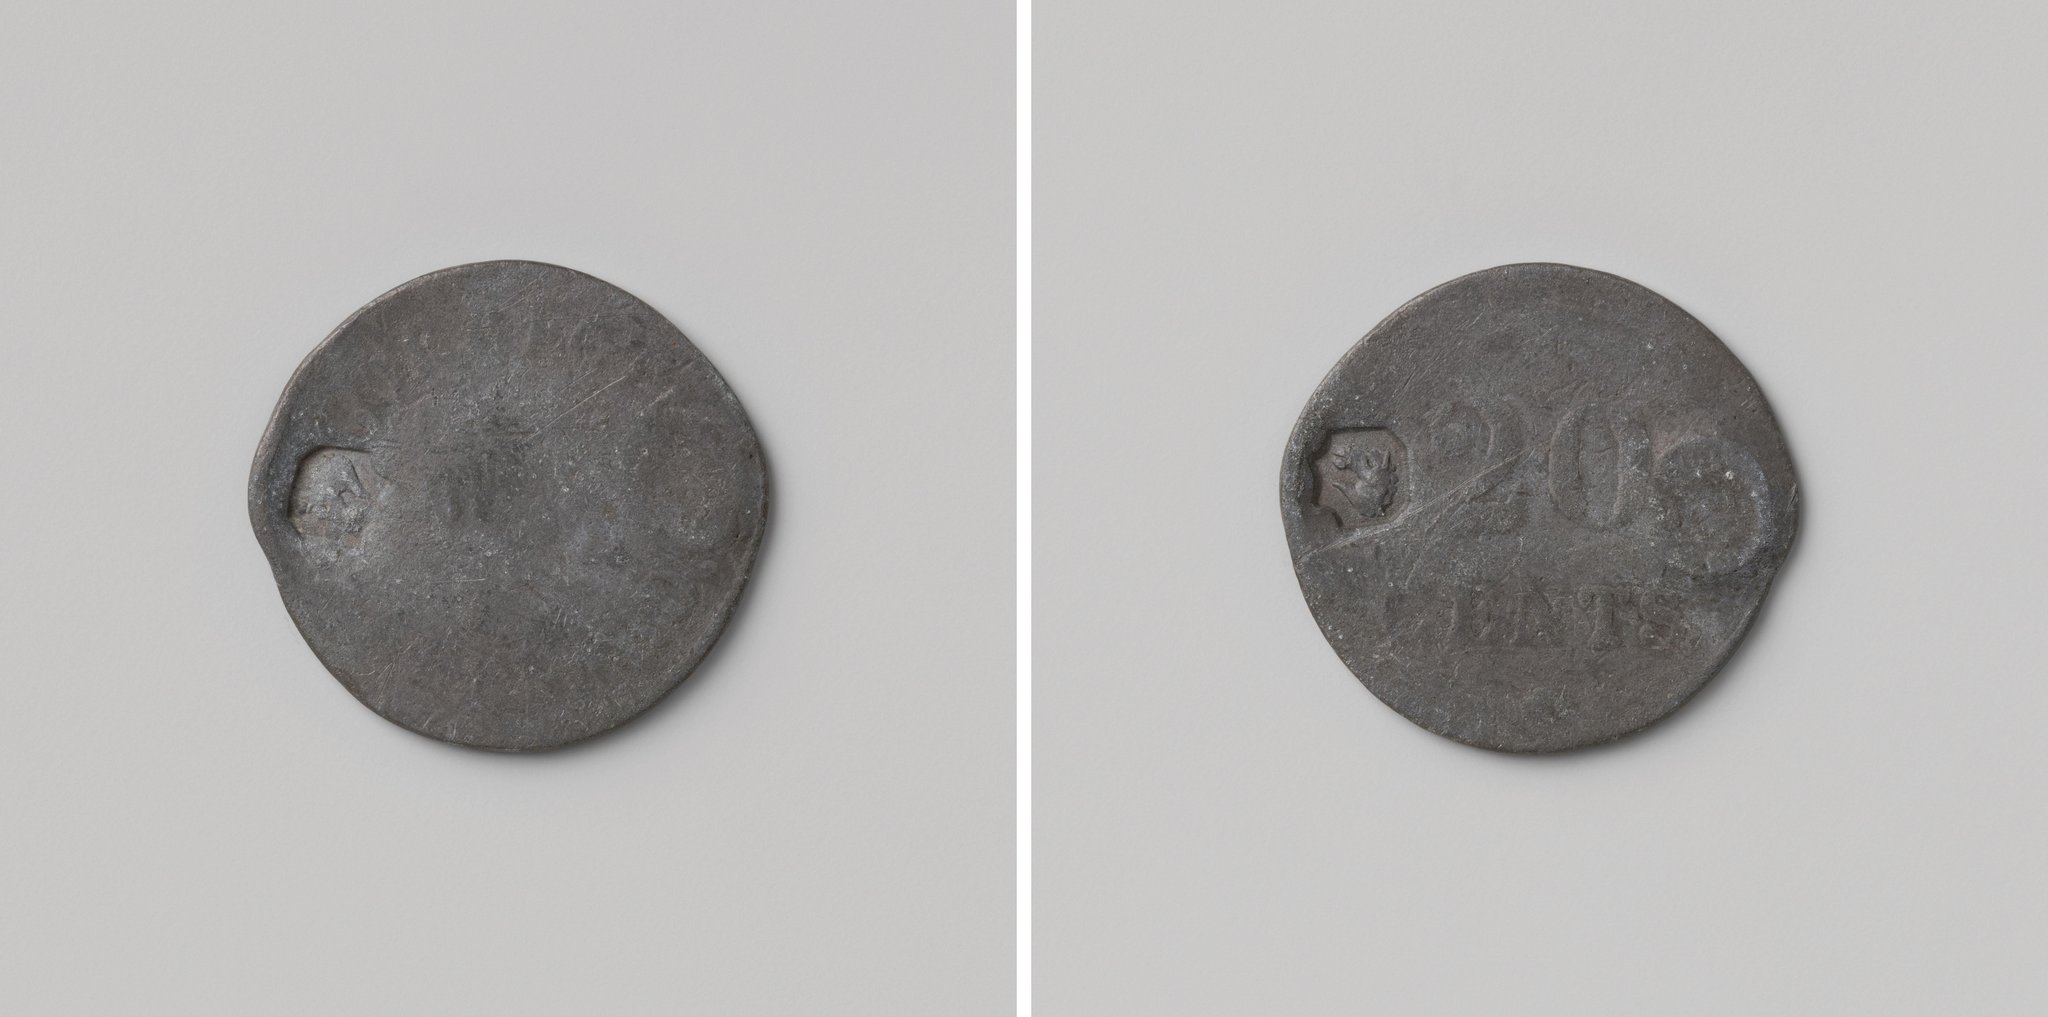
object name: twintig cent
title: Correctiehuis Sint Bernhard te Hemiksem, huismunt ter waarde van twintig cents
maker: joseph pierre braemt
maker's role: print maker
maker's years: 1796-1864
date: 1826-1833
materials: zinc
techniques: striking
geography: brussels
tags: ghent